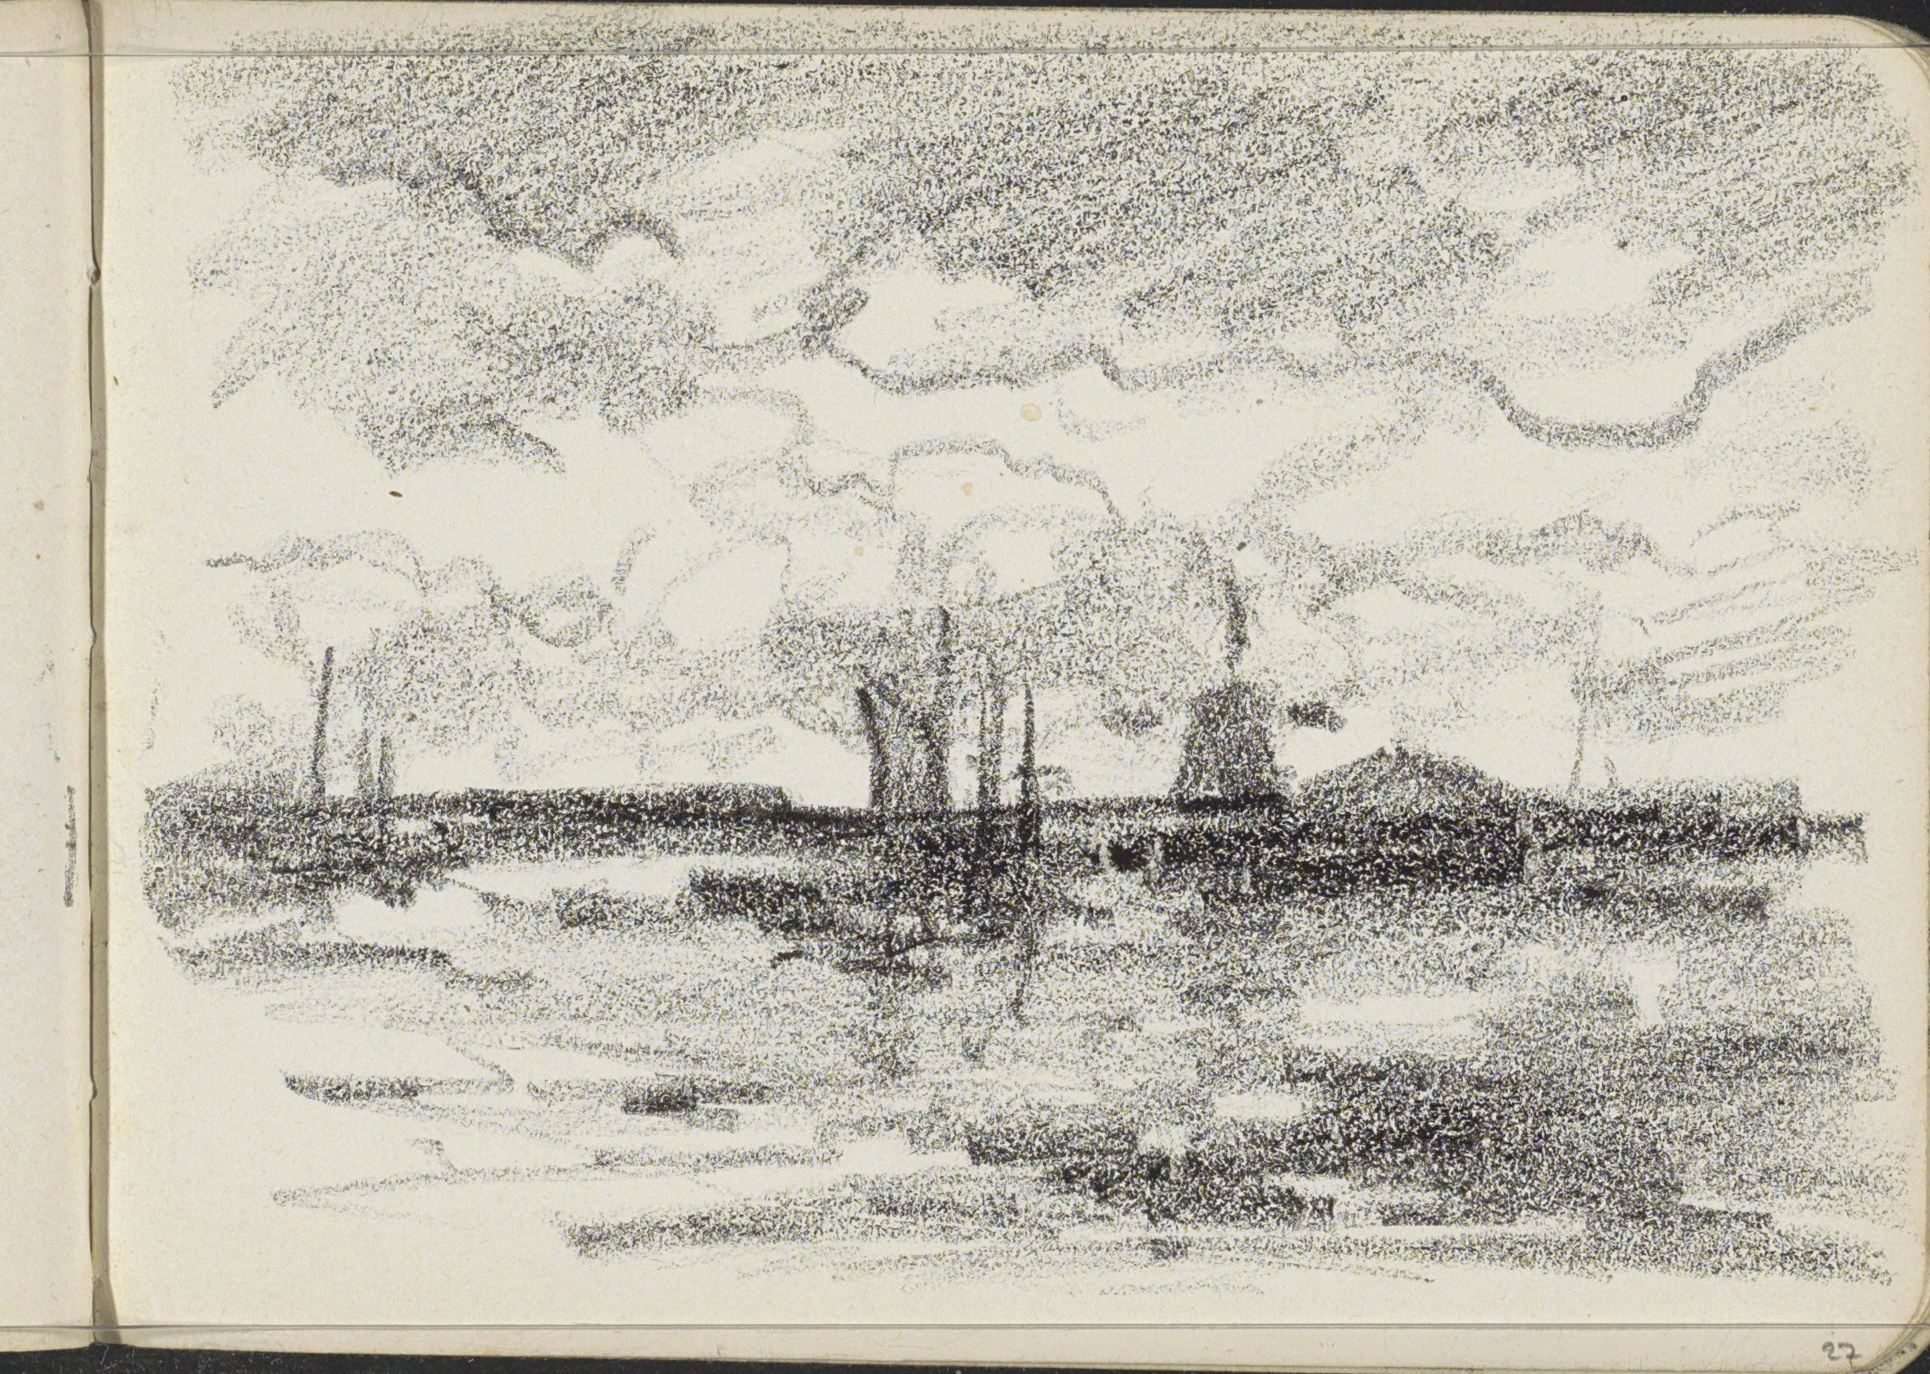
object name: sketchbook leaf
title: Landschap met een molen aan het water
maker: willem cornelis rip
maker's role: draughtsman, painter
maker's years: 1856-1922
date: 1907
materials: chalk, paper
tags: landscapes with waters, waterscapes, seascapes (in the temperate zone), windmill in landscape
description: Blad 27 recto uit een schetsboek met 41 bladen.